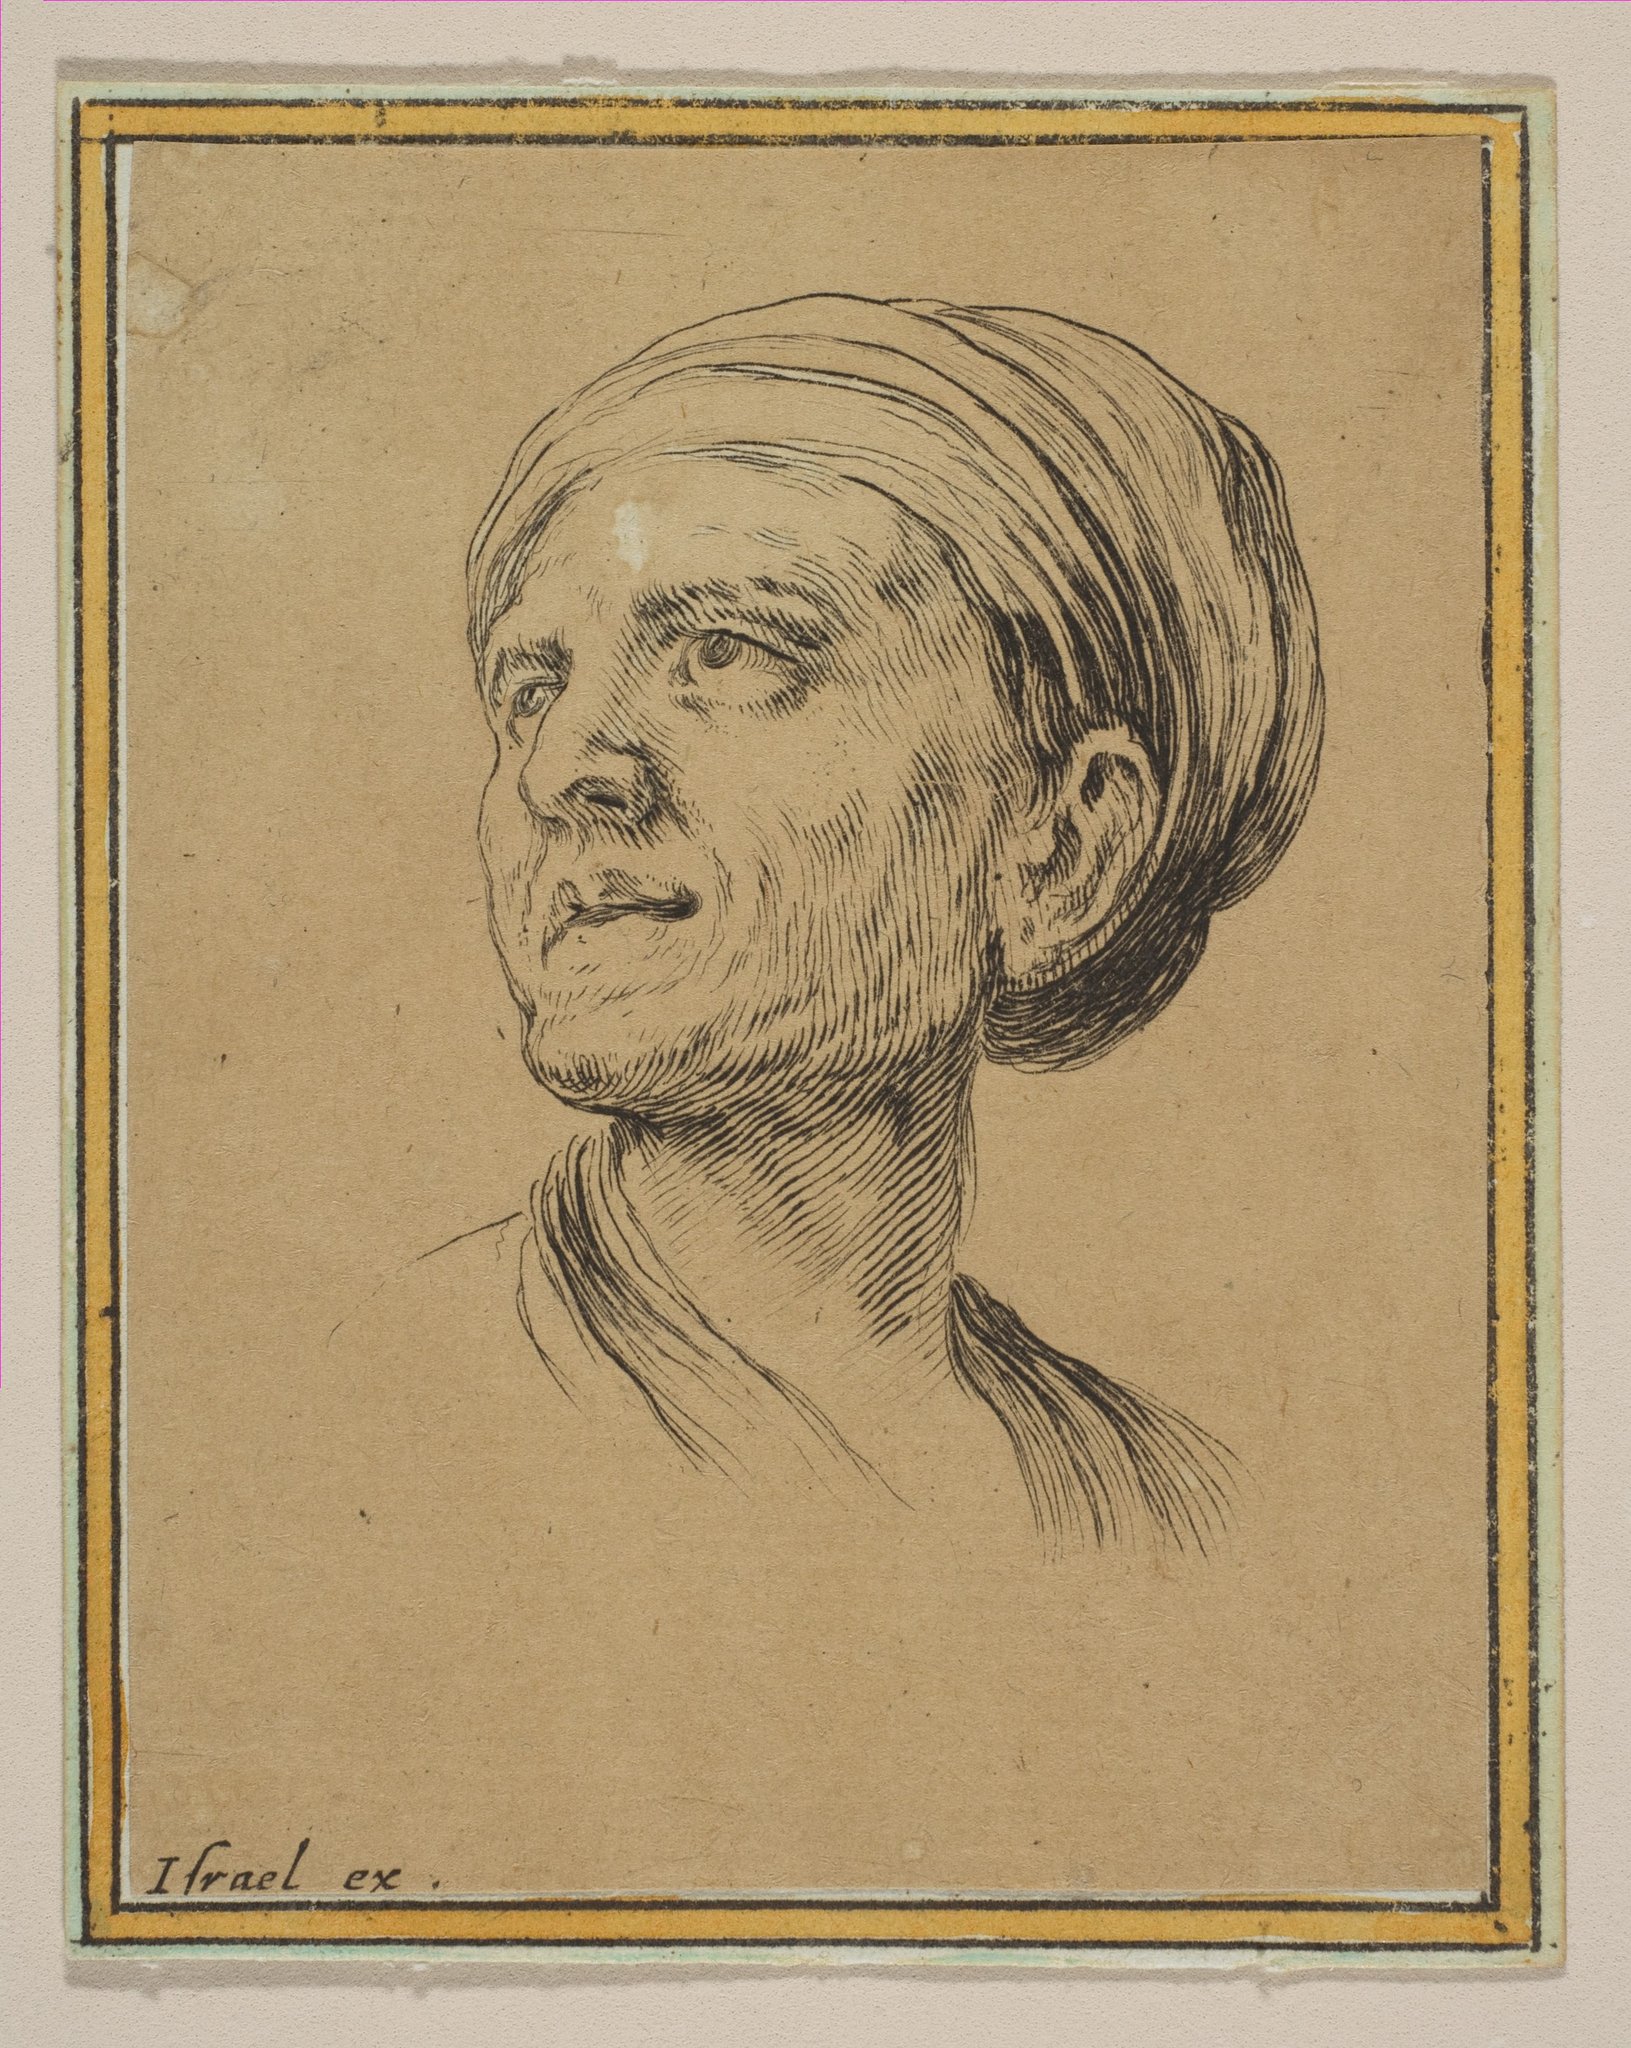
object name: print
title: Head of a Woman in Three Quarter View, from "Various heads and figures" (Diverses tétes et figures)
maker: stefano della bella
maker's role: artist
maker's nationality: italian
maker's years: 1610-1664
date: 1650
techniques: etching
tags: portraits,women